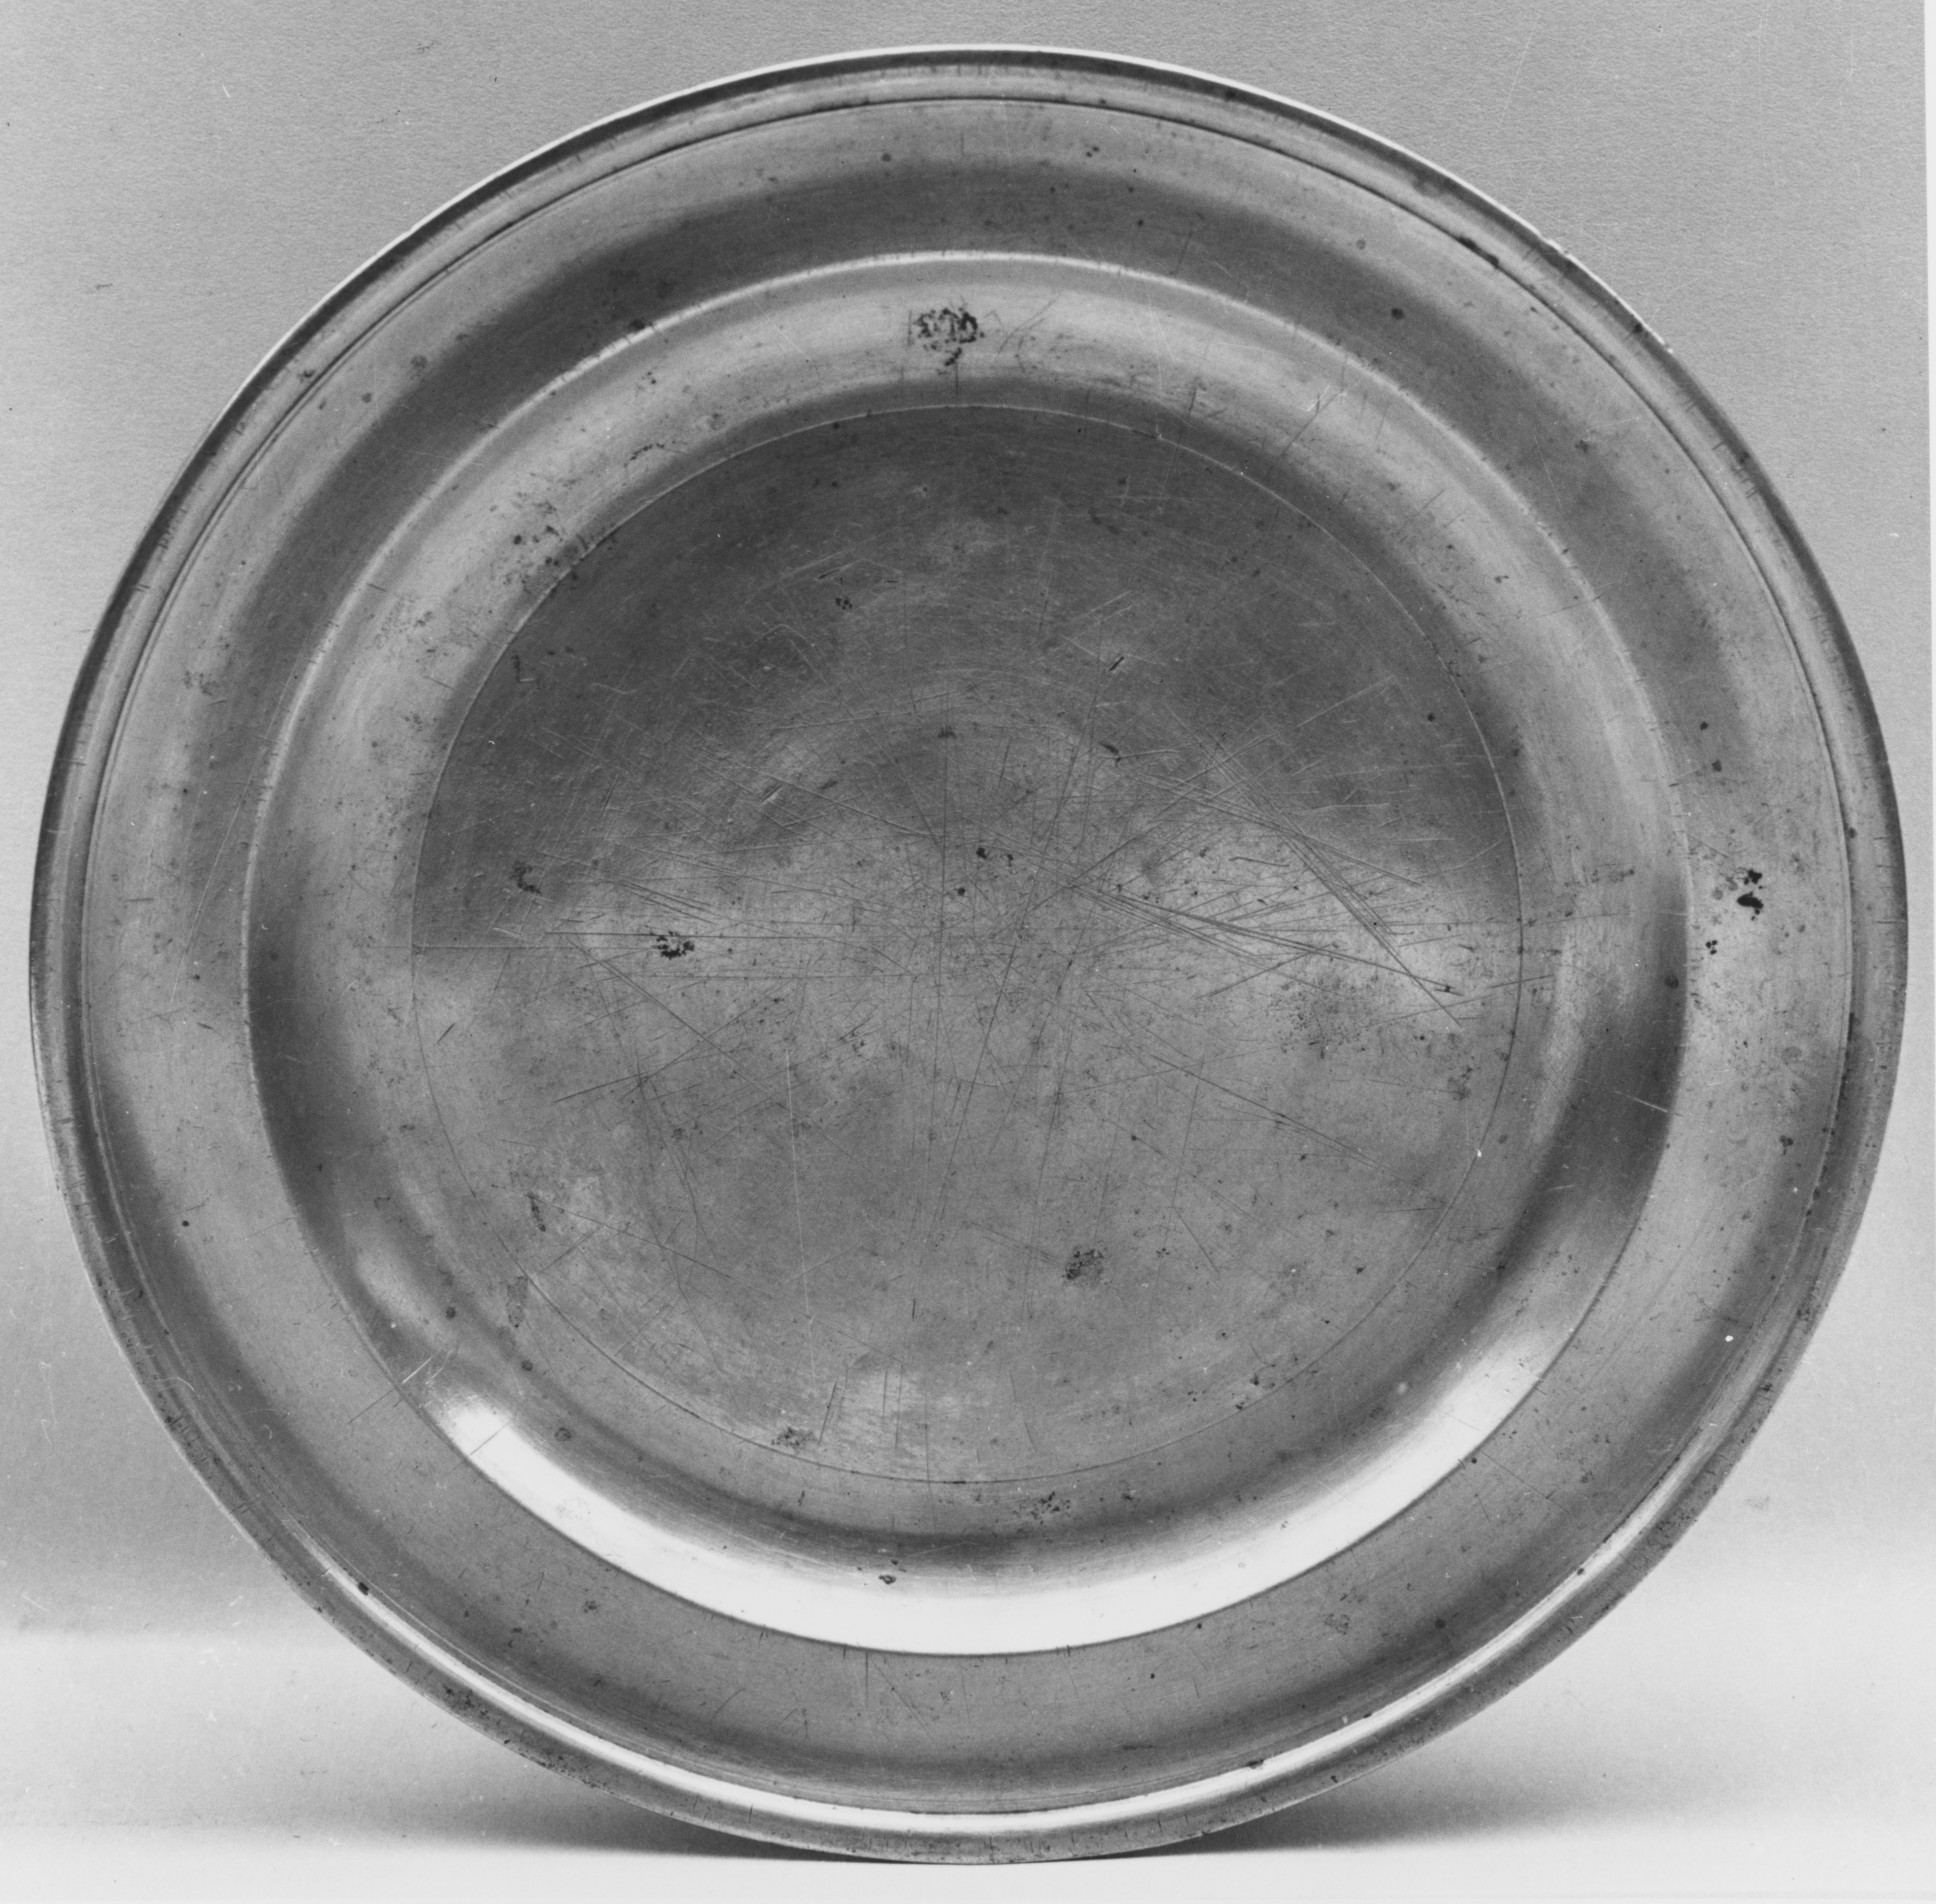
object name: plate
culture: american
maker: thomas badger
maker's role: maker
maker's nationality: american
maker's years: 1764-1826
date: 1787-1815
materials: pewter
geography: united states